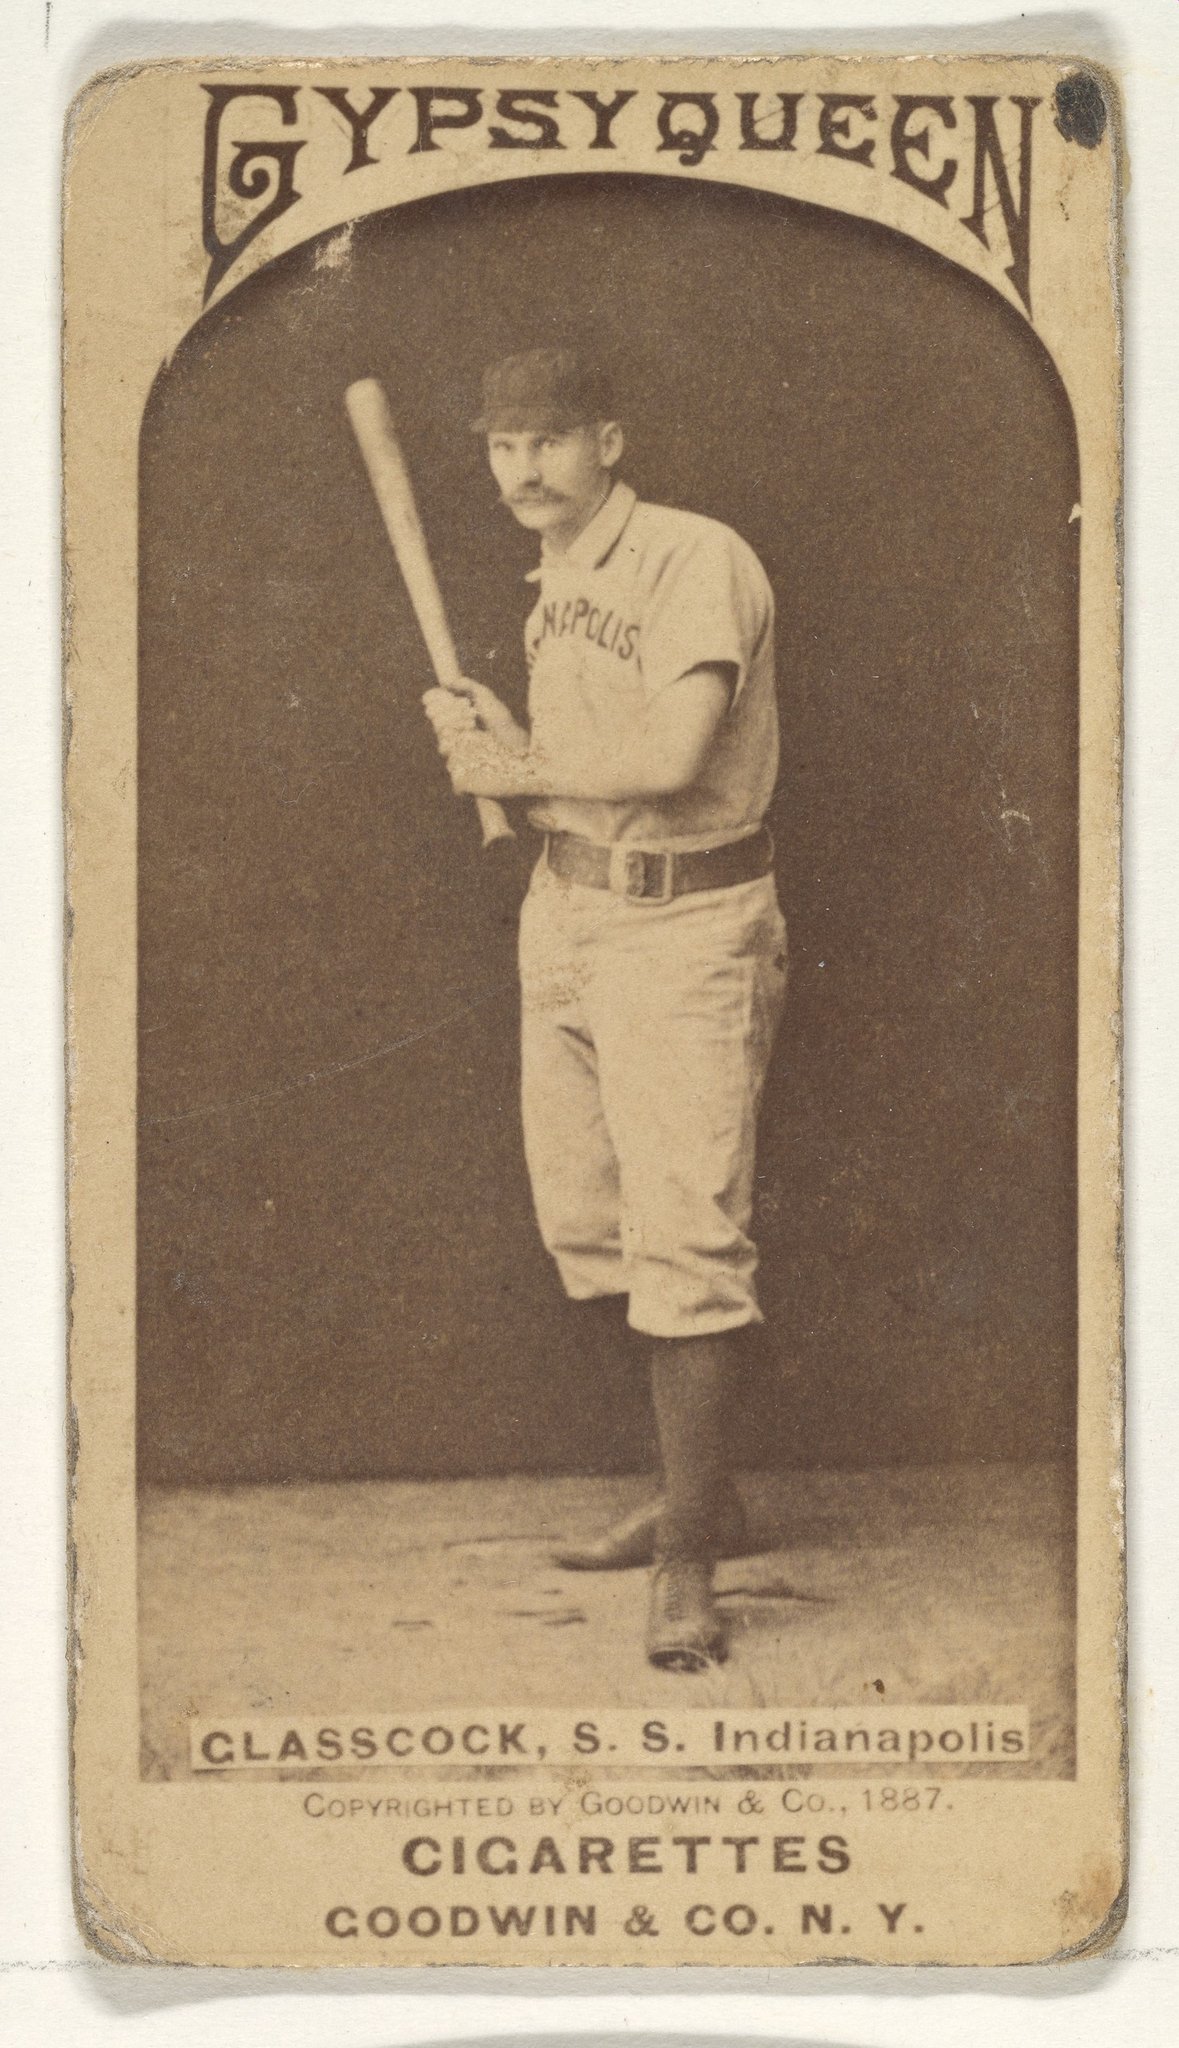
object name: baseball card, photograph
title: Glasscock, Shortstop, Indianapolis, from the Old Judge series (N172) for Gypsy Queen and Old Judge Cigarettes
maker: goodwin & company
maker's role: publisher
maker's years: 1850-1950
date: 1887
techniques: albumen silver print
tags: men,portraits,baseball,athletes